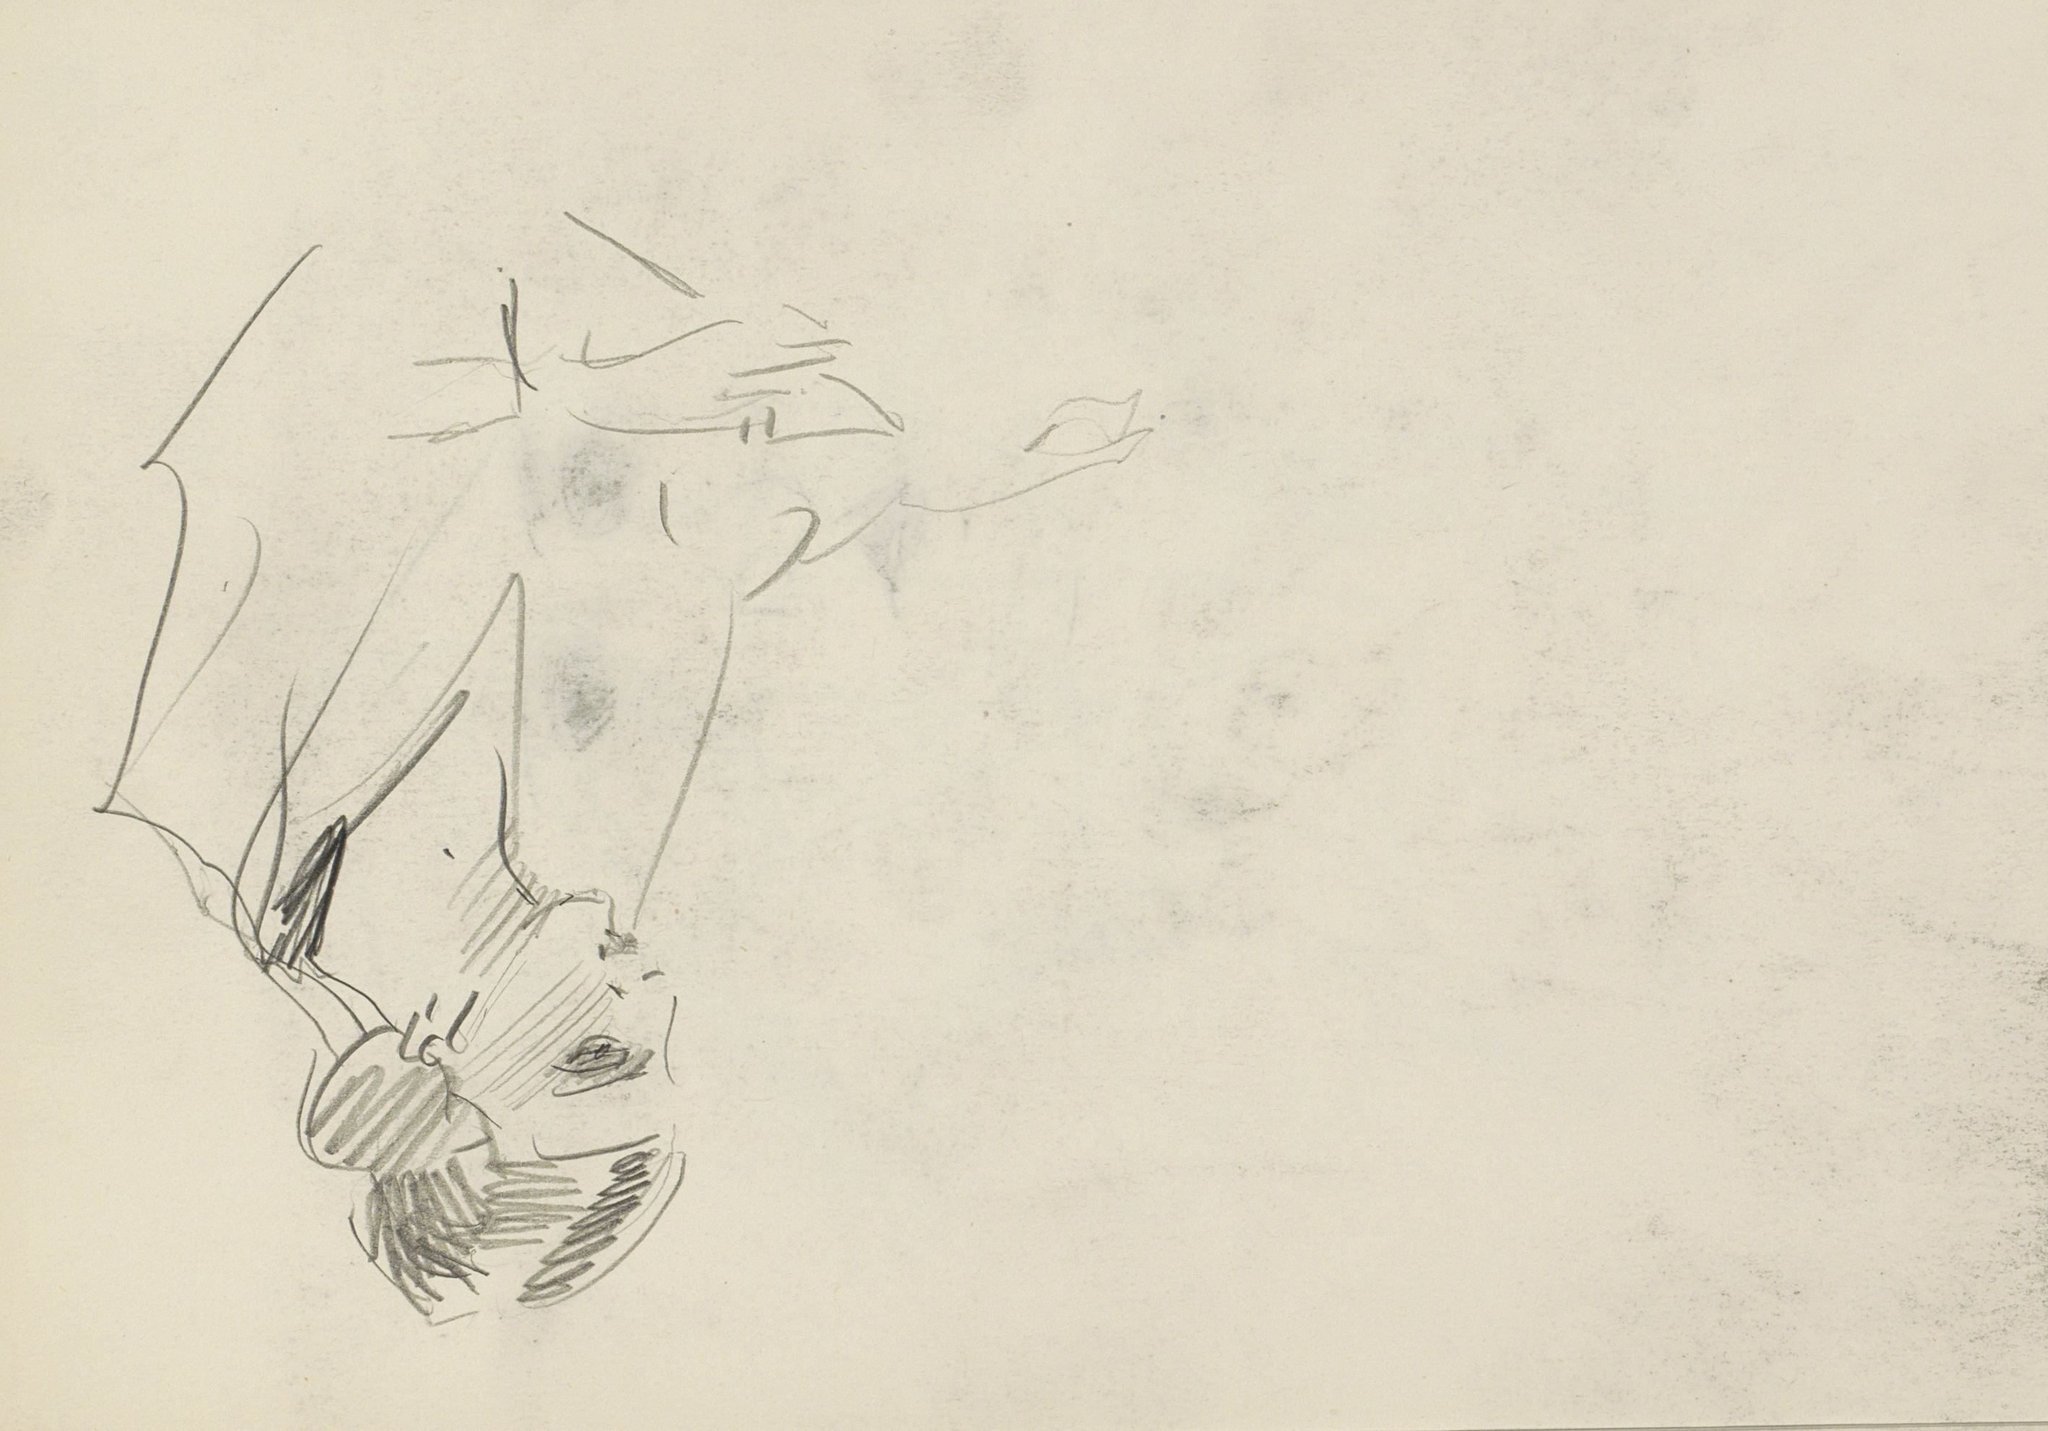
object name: sketchbook leaf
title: Vrouw, in profiel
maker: isaac israels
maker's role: draughtsman, painter, print maker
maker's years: 1865-1934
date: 1915-1934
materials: paper, pencil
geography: the hague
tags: adult woman (+ sideview, profile)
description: Blad 7 verso uit schetsboek XXV met 23 bladen.